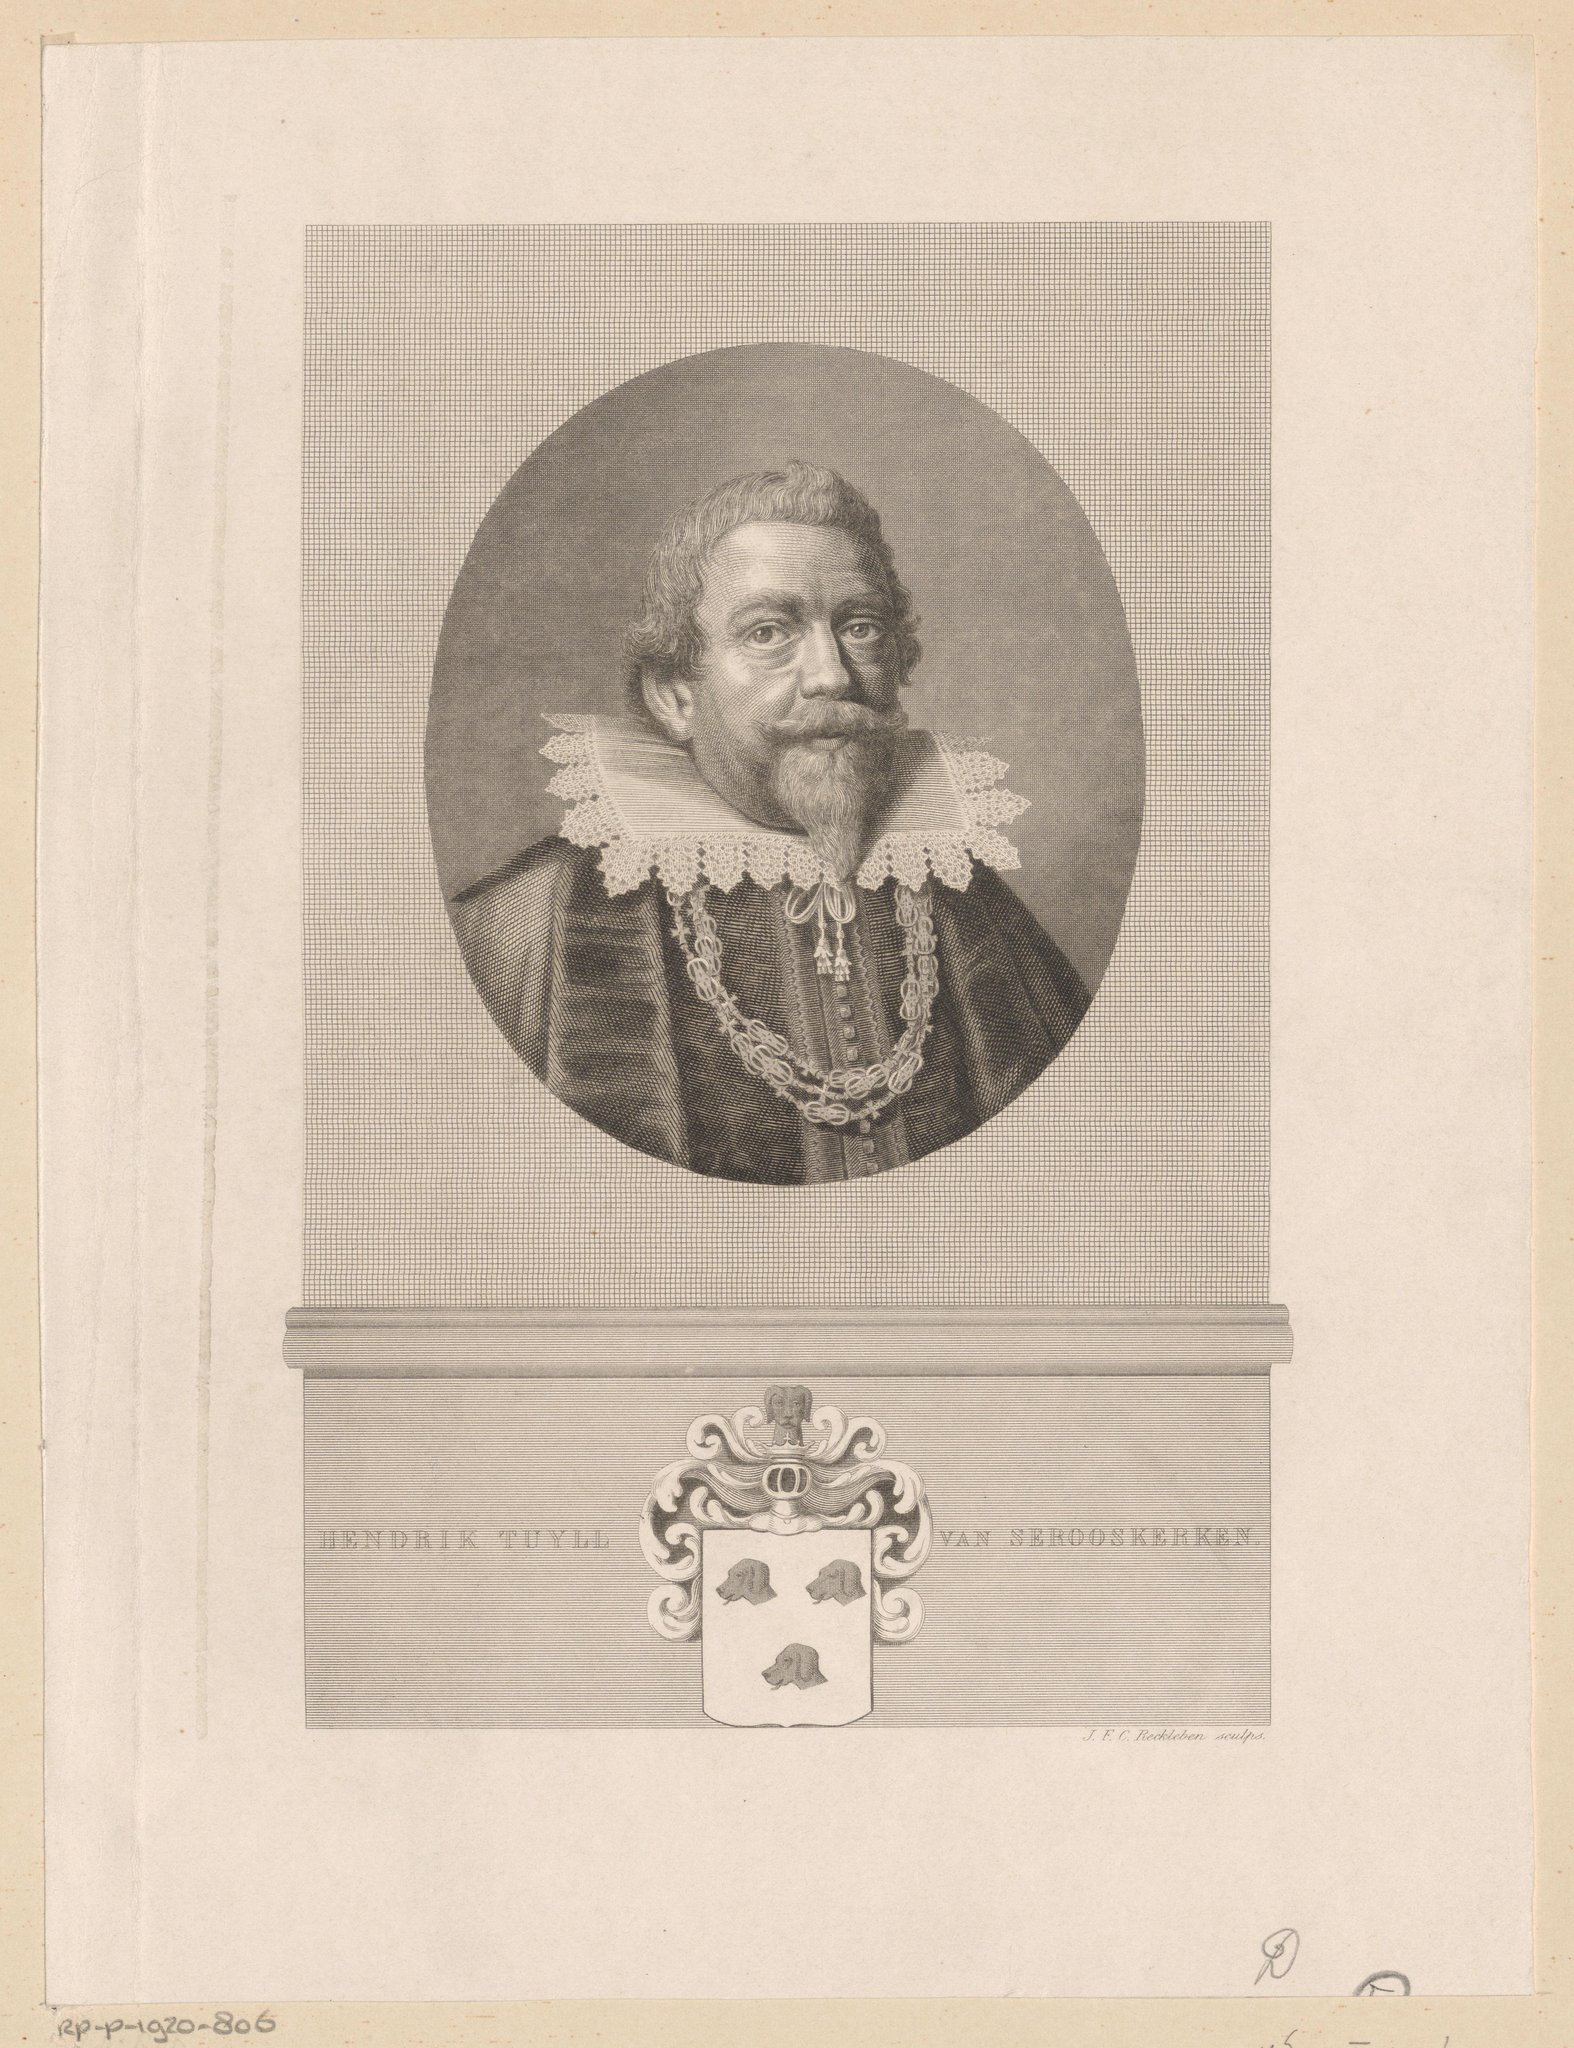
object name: print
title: Portret van Hendrick Tuyll van Serooskerken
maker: jan frederik christiaan reckleben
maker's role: print maker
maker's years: 1819-1879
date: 1860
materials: paper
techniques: engraving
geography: amsterdam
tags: lierre, historical persons, armorial bearing, heraldry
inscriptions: collector's mark: Lugt 2228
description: Prent waarschijnlijk uit: Rees, Otto van, en Brill, Willem Gerard. Algemeene geschiedenis des vaderlands van de vroegste tijden tot op heden. Amsterdam: Schleijer, J.F. 1860, dl. 3.3, p. 675.